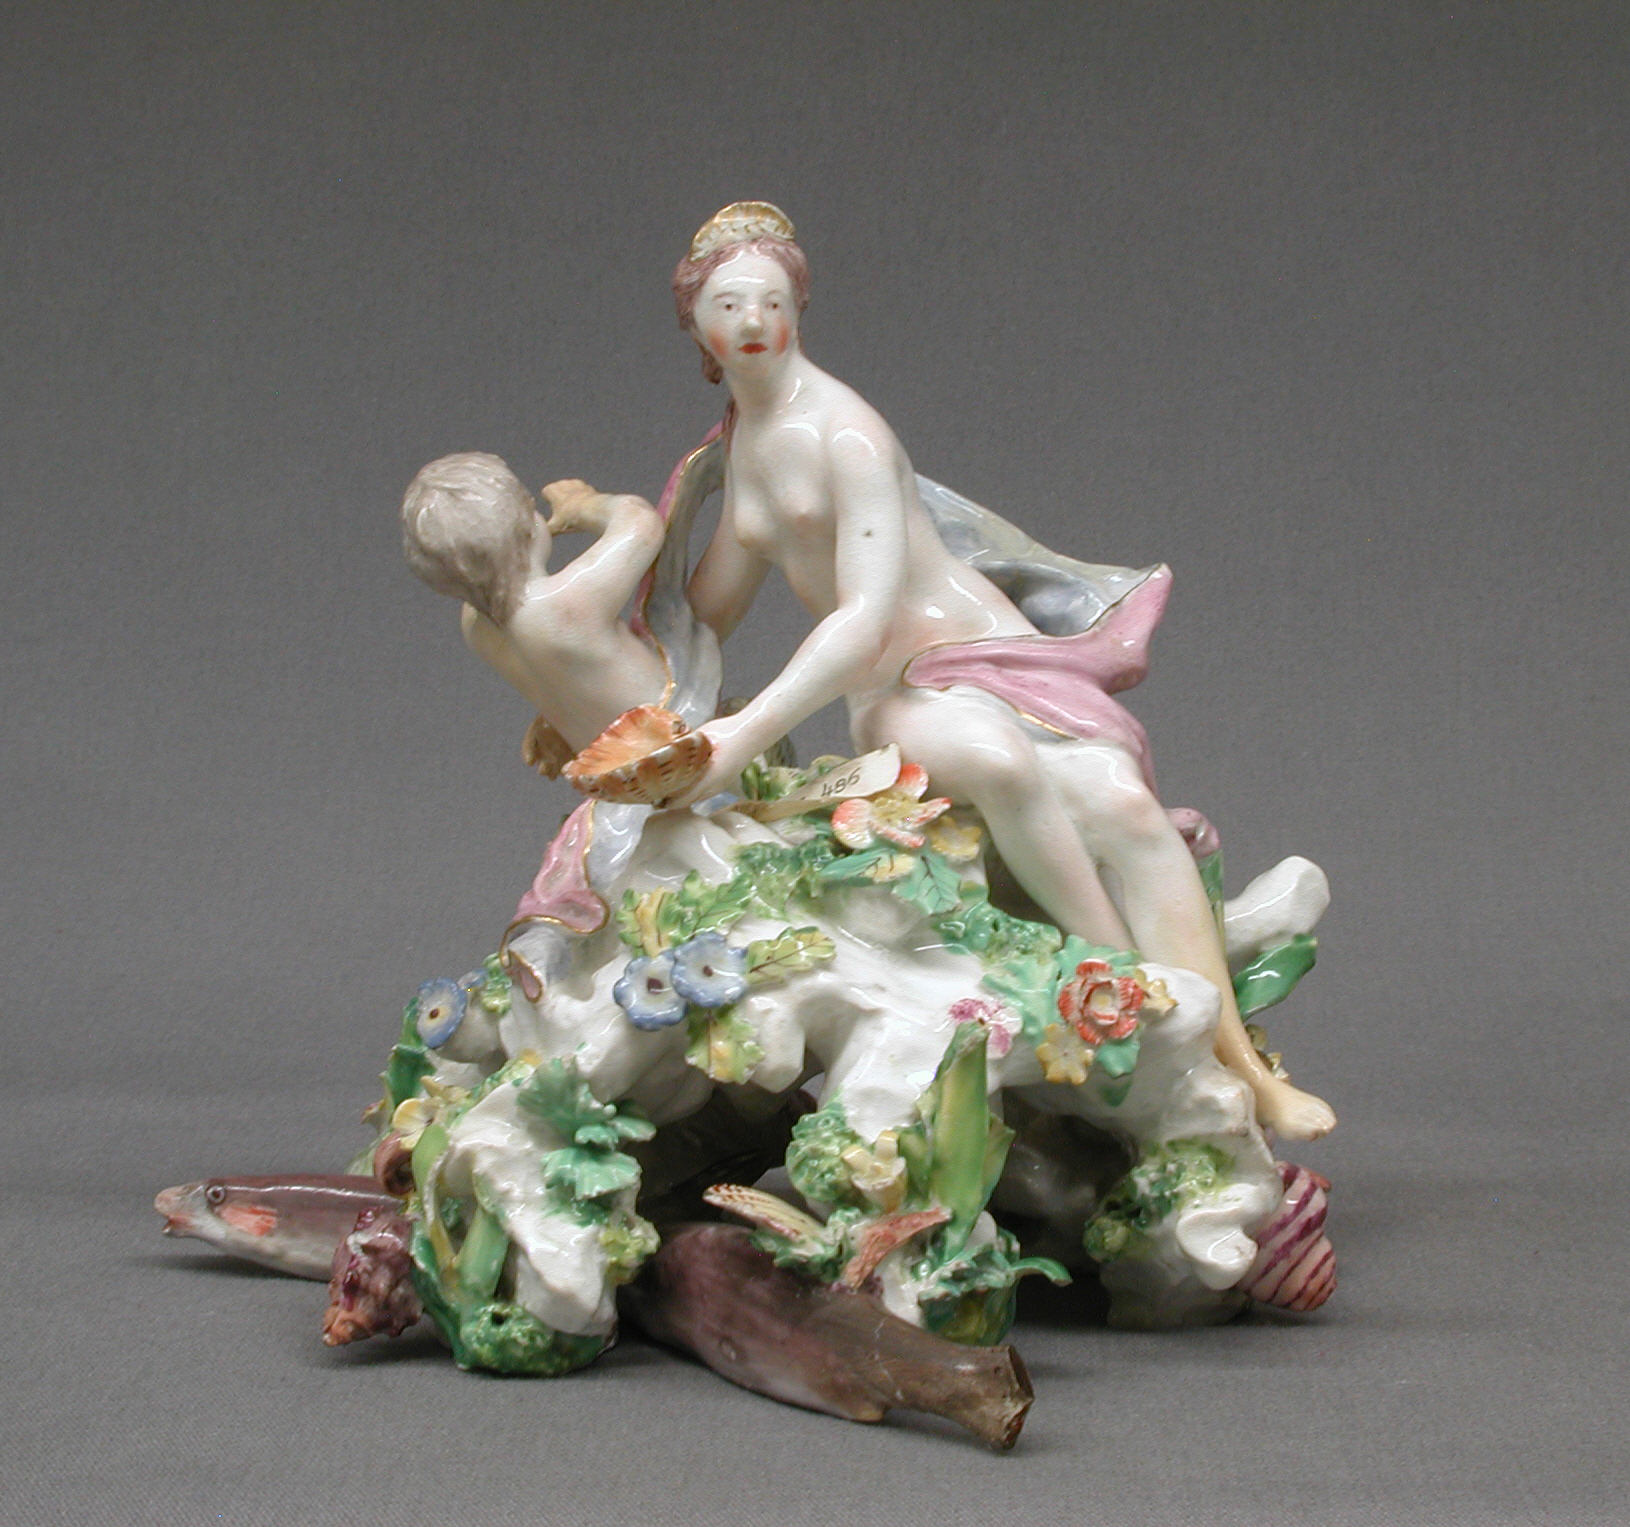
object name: group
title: Triumph of Galathea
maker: chelsea porcelain manufactory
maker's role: factory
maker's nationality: british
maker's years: 1744-1784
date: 1755-1756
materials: soft paste porcelain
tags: female nudes,fish,flowers,leaves